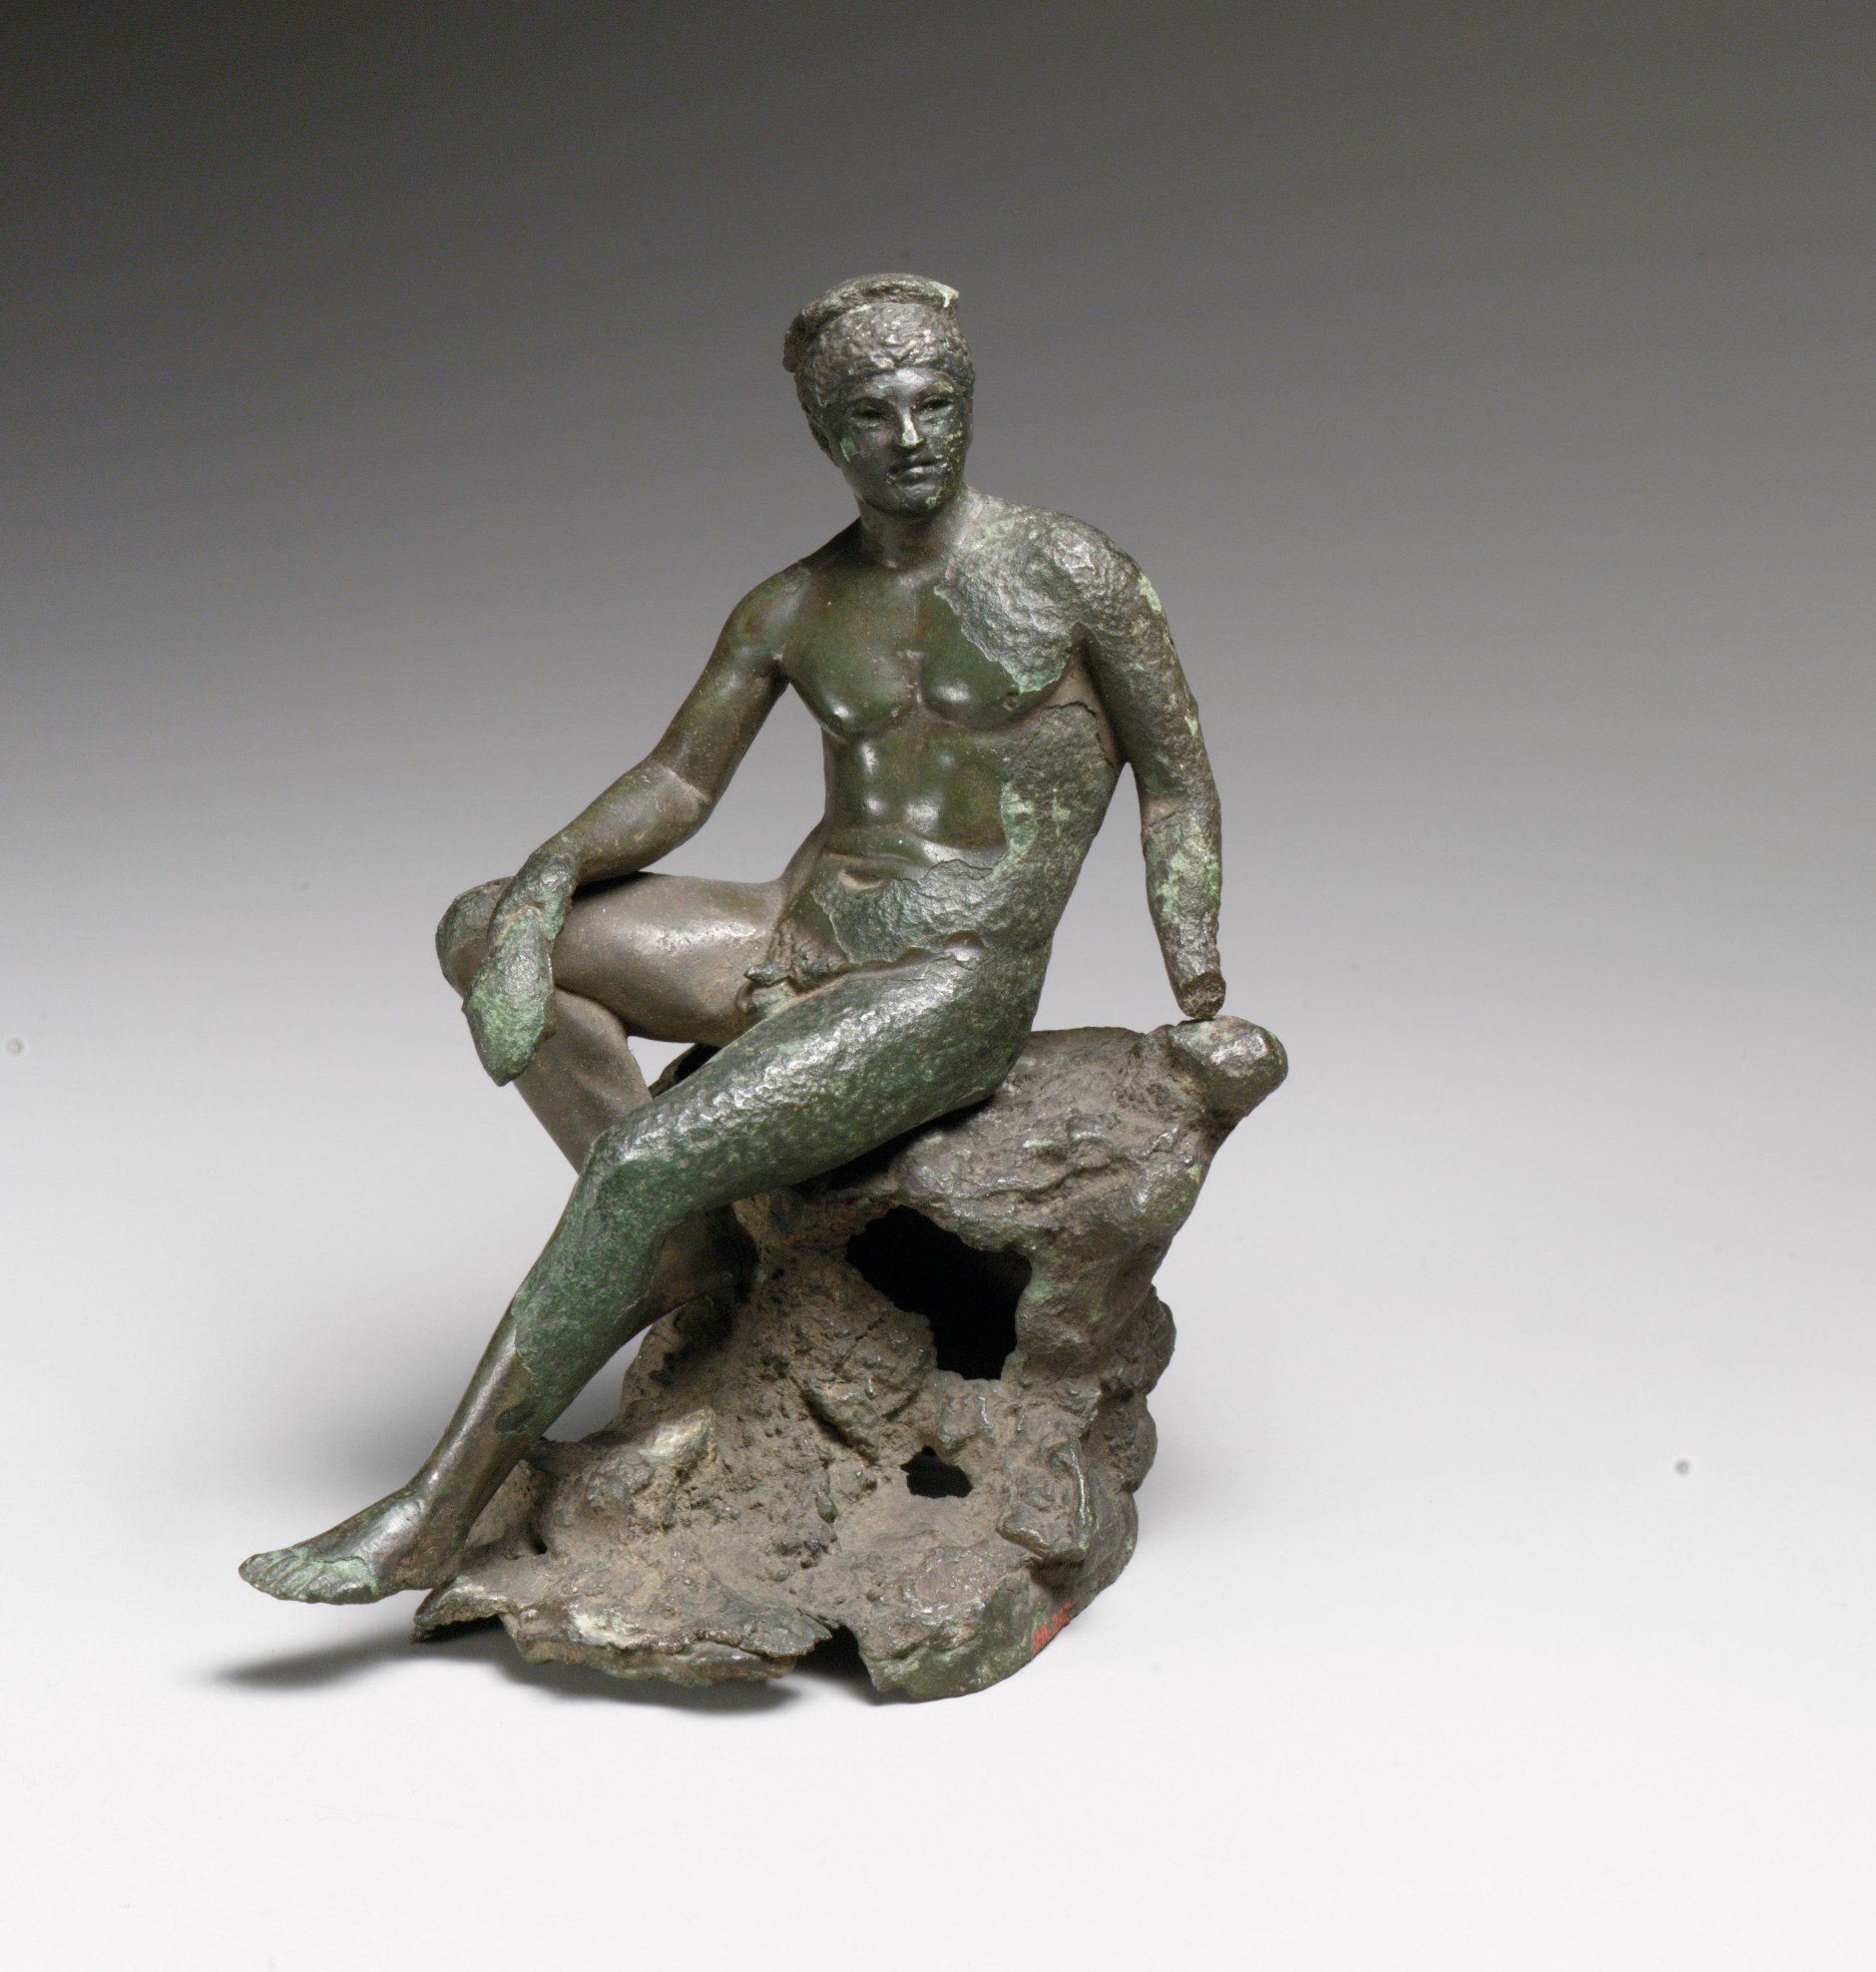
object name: statuette of hermes holding a purse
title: Bronze statuette of Hermes seated on a rock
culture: roman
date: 1-200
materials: bronze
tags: hermes